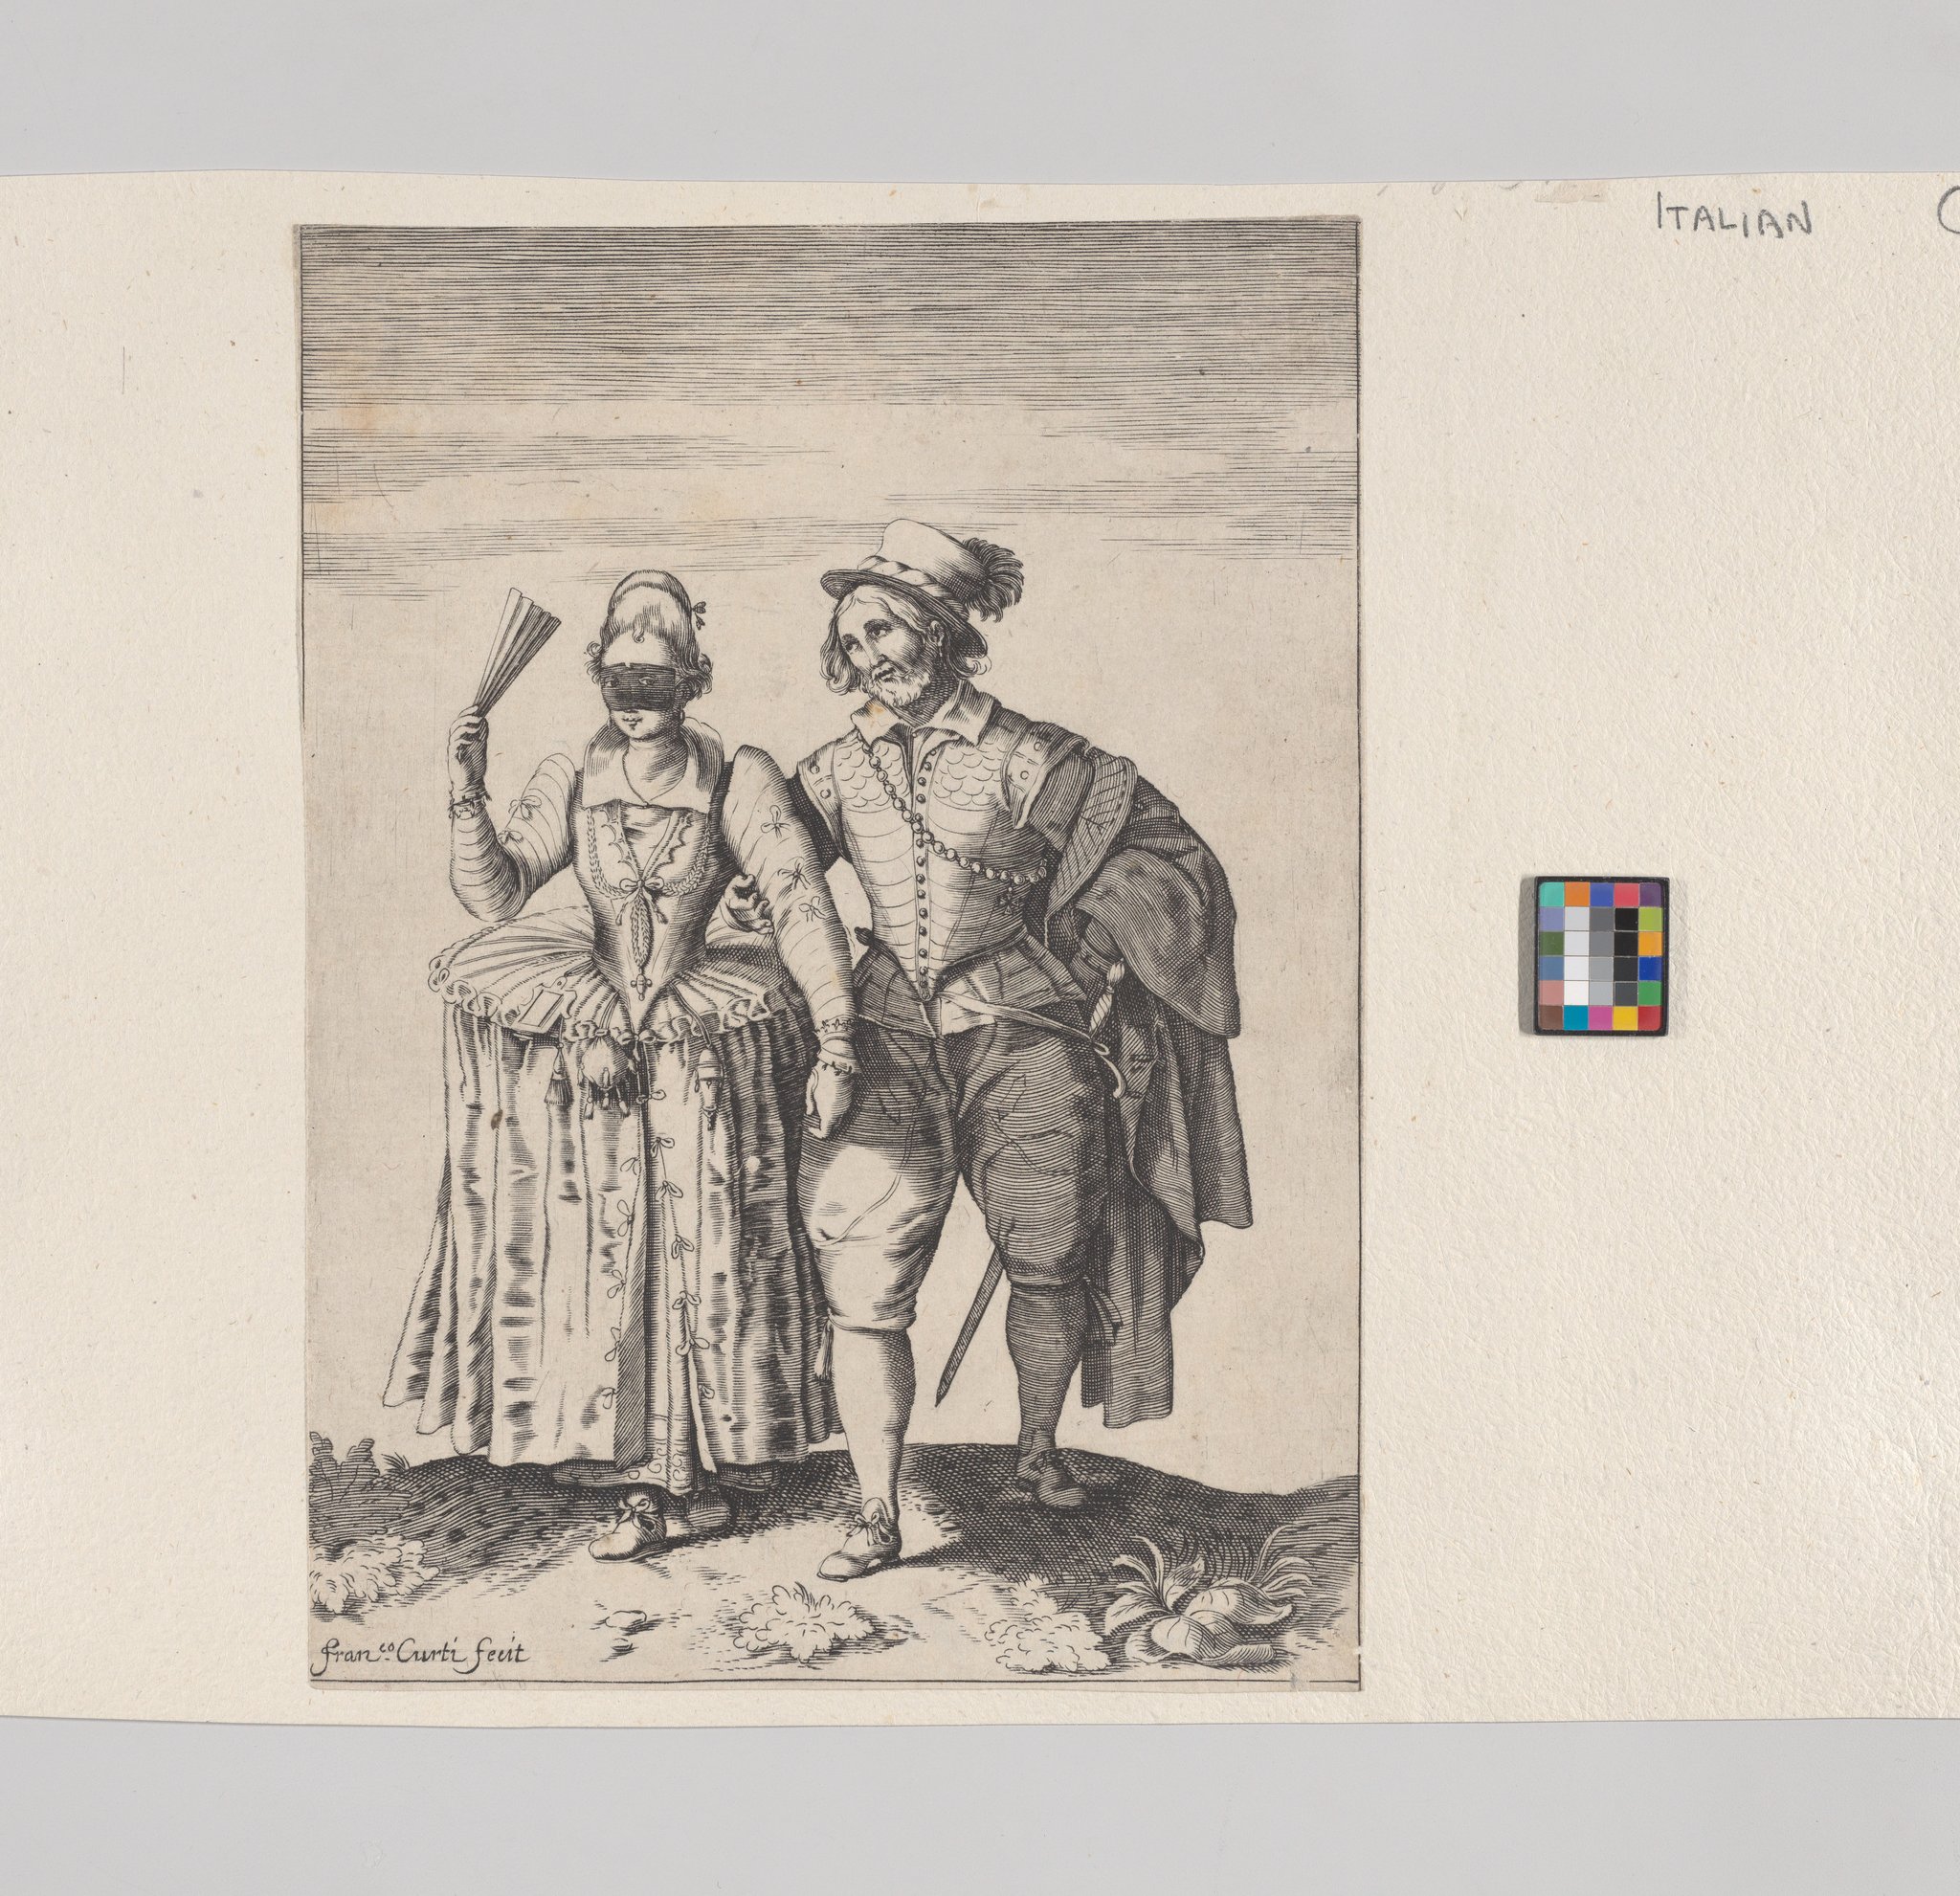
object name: print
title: A couple walking, the woman at left wears a mask and carries a fan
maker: bernardino curti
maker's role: artist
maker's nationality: italian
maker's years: 1611-1679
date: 1630-1679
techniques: engraving, etching